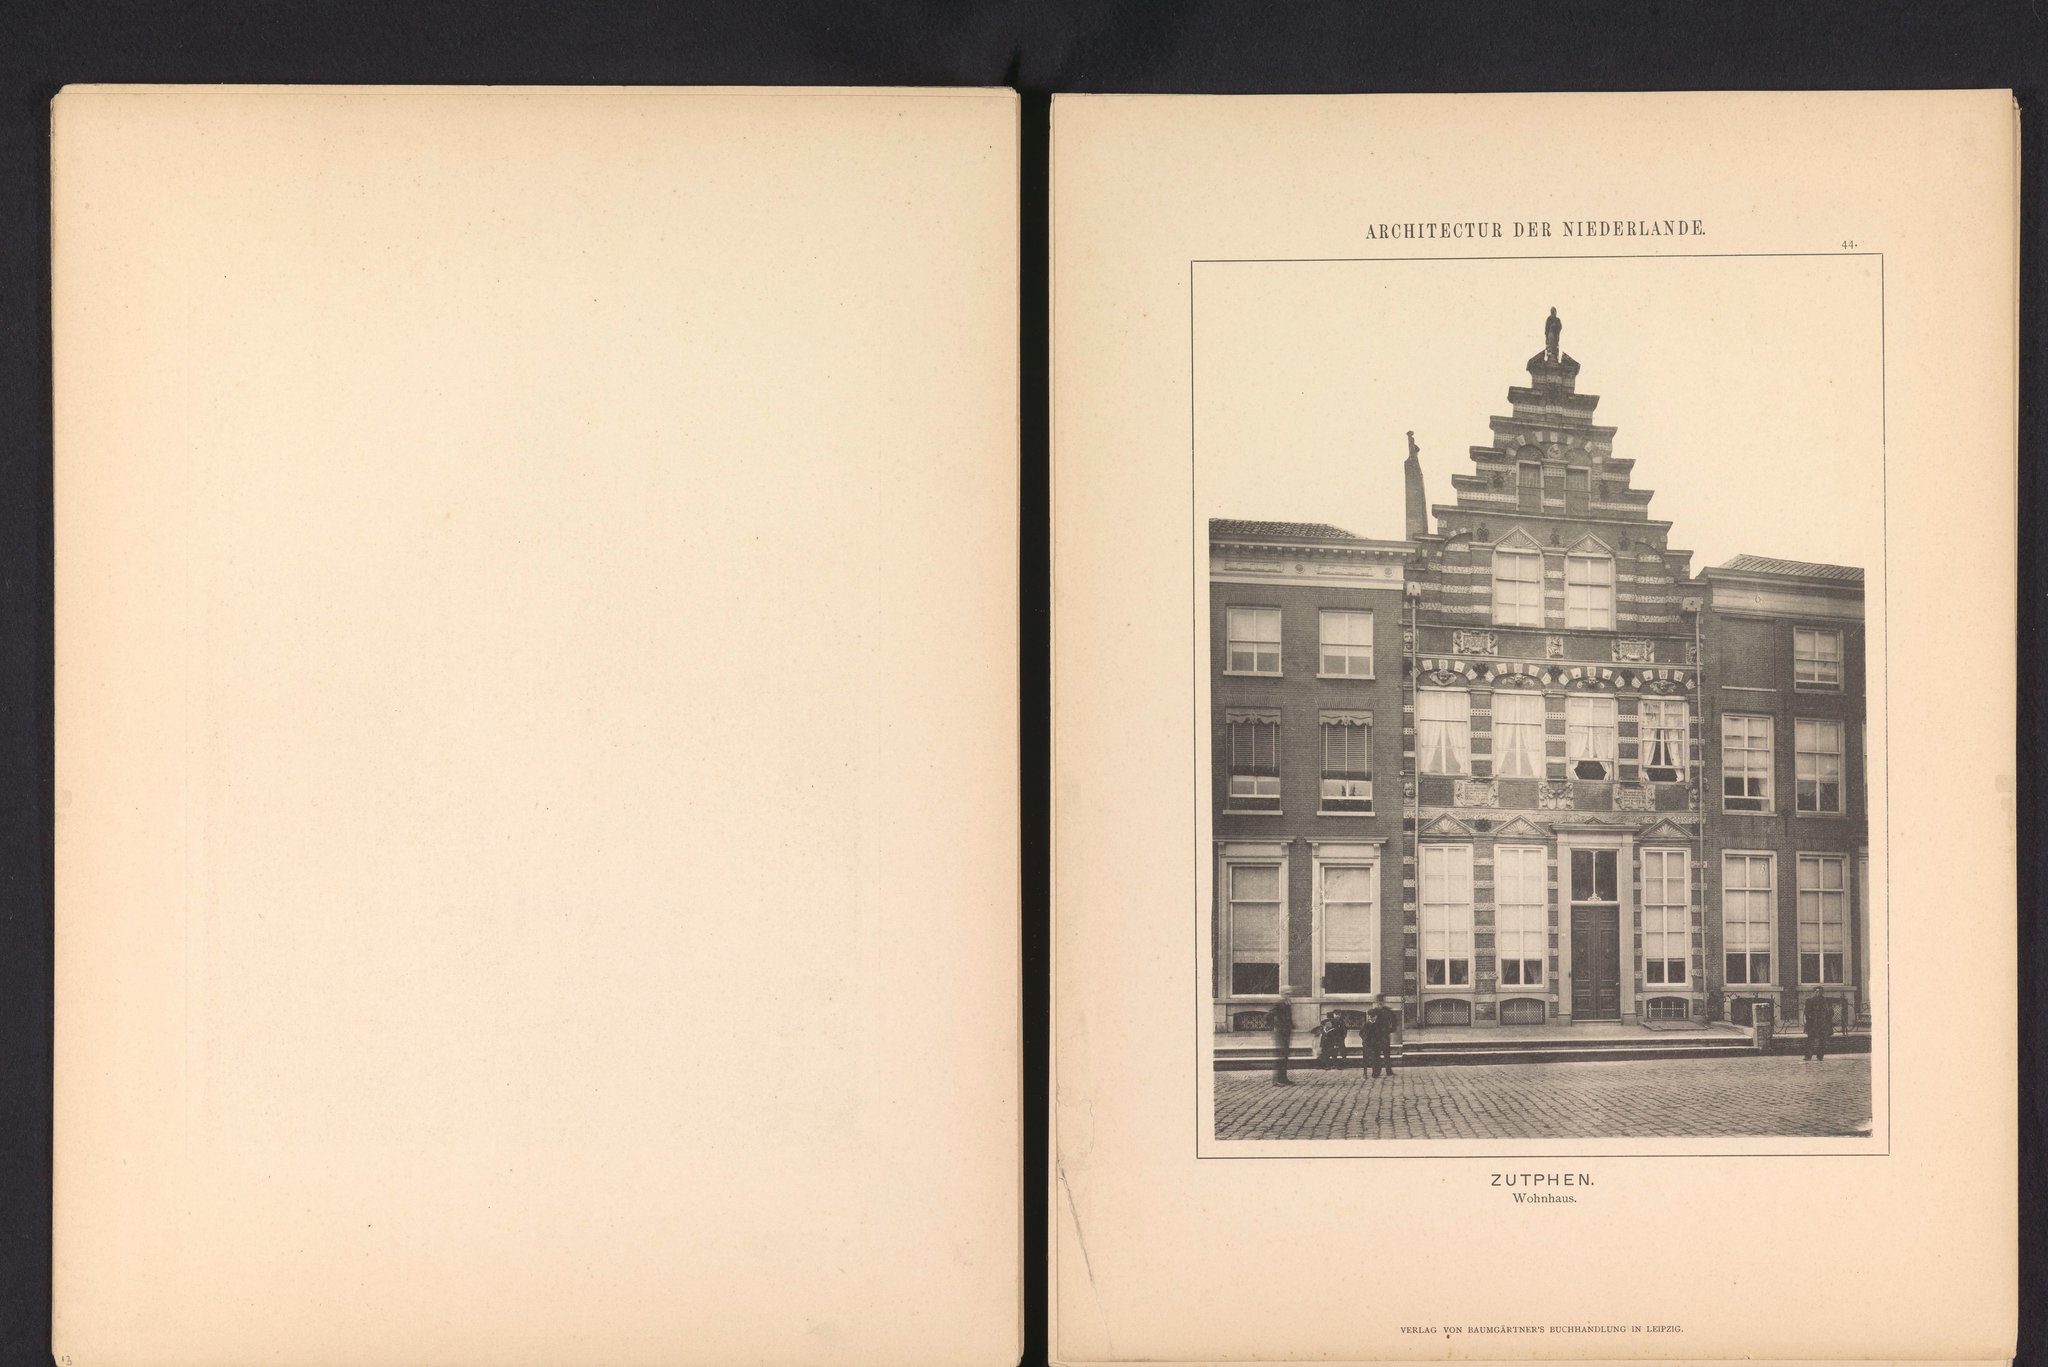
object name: page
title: Zutphen. Wohnhaus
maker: Anonymous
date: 1884-1894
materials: paper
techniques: photograph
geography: leipzig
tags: decorated gable, stone tablet in façade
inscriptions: number: ‘44.’